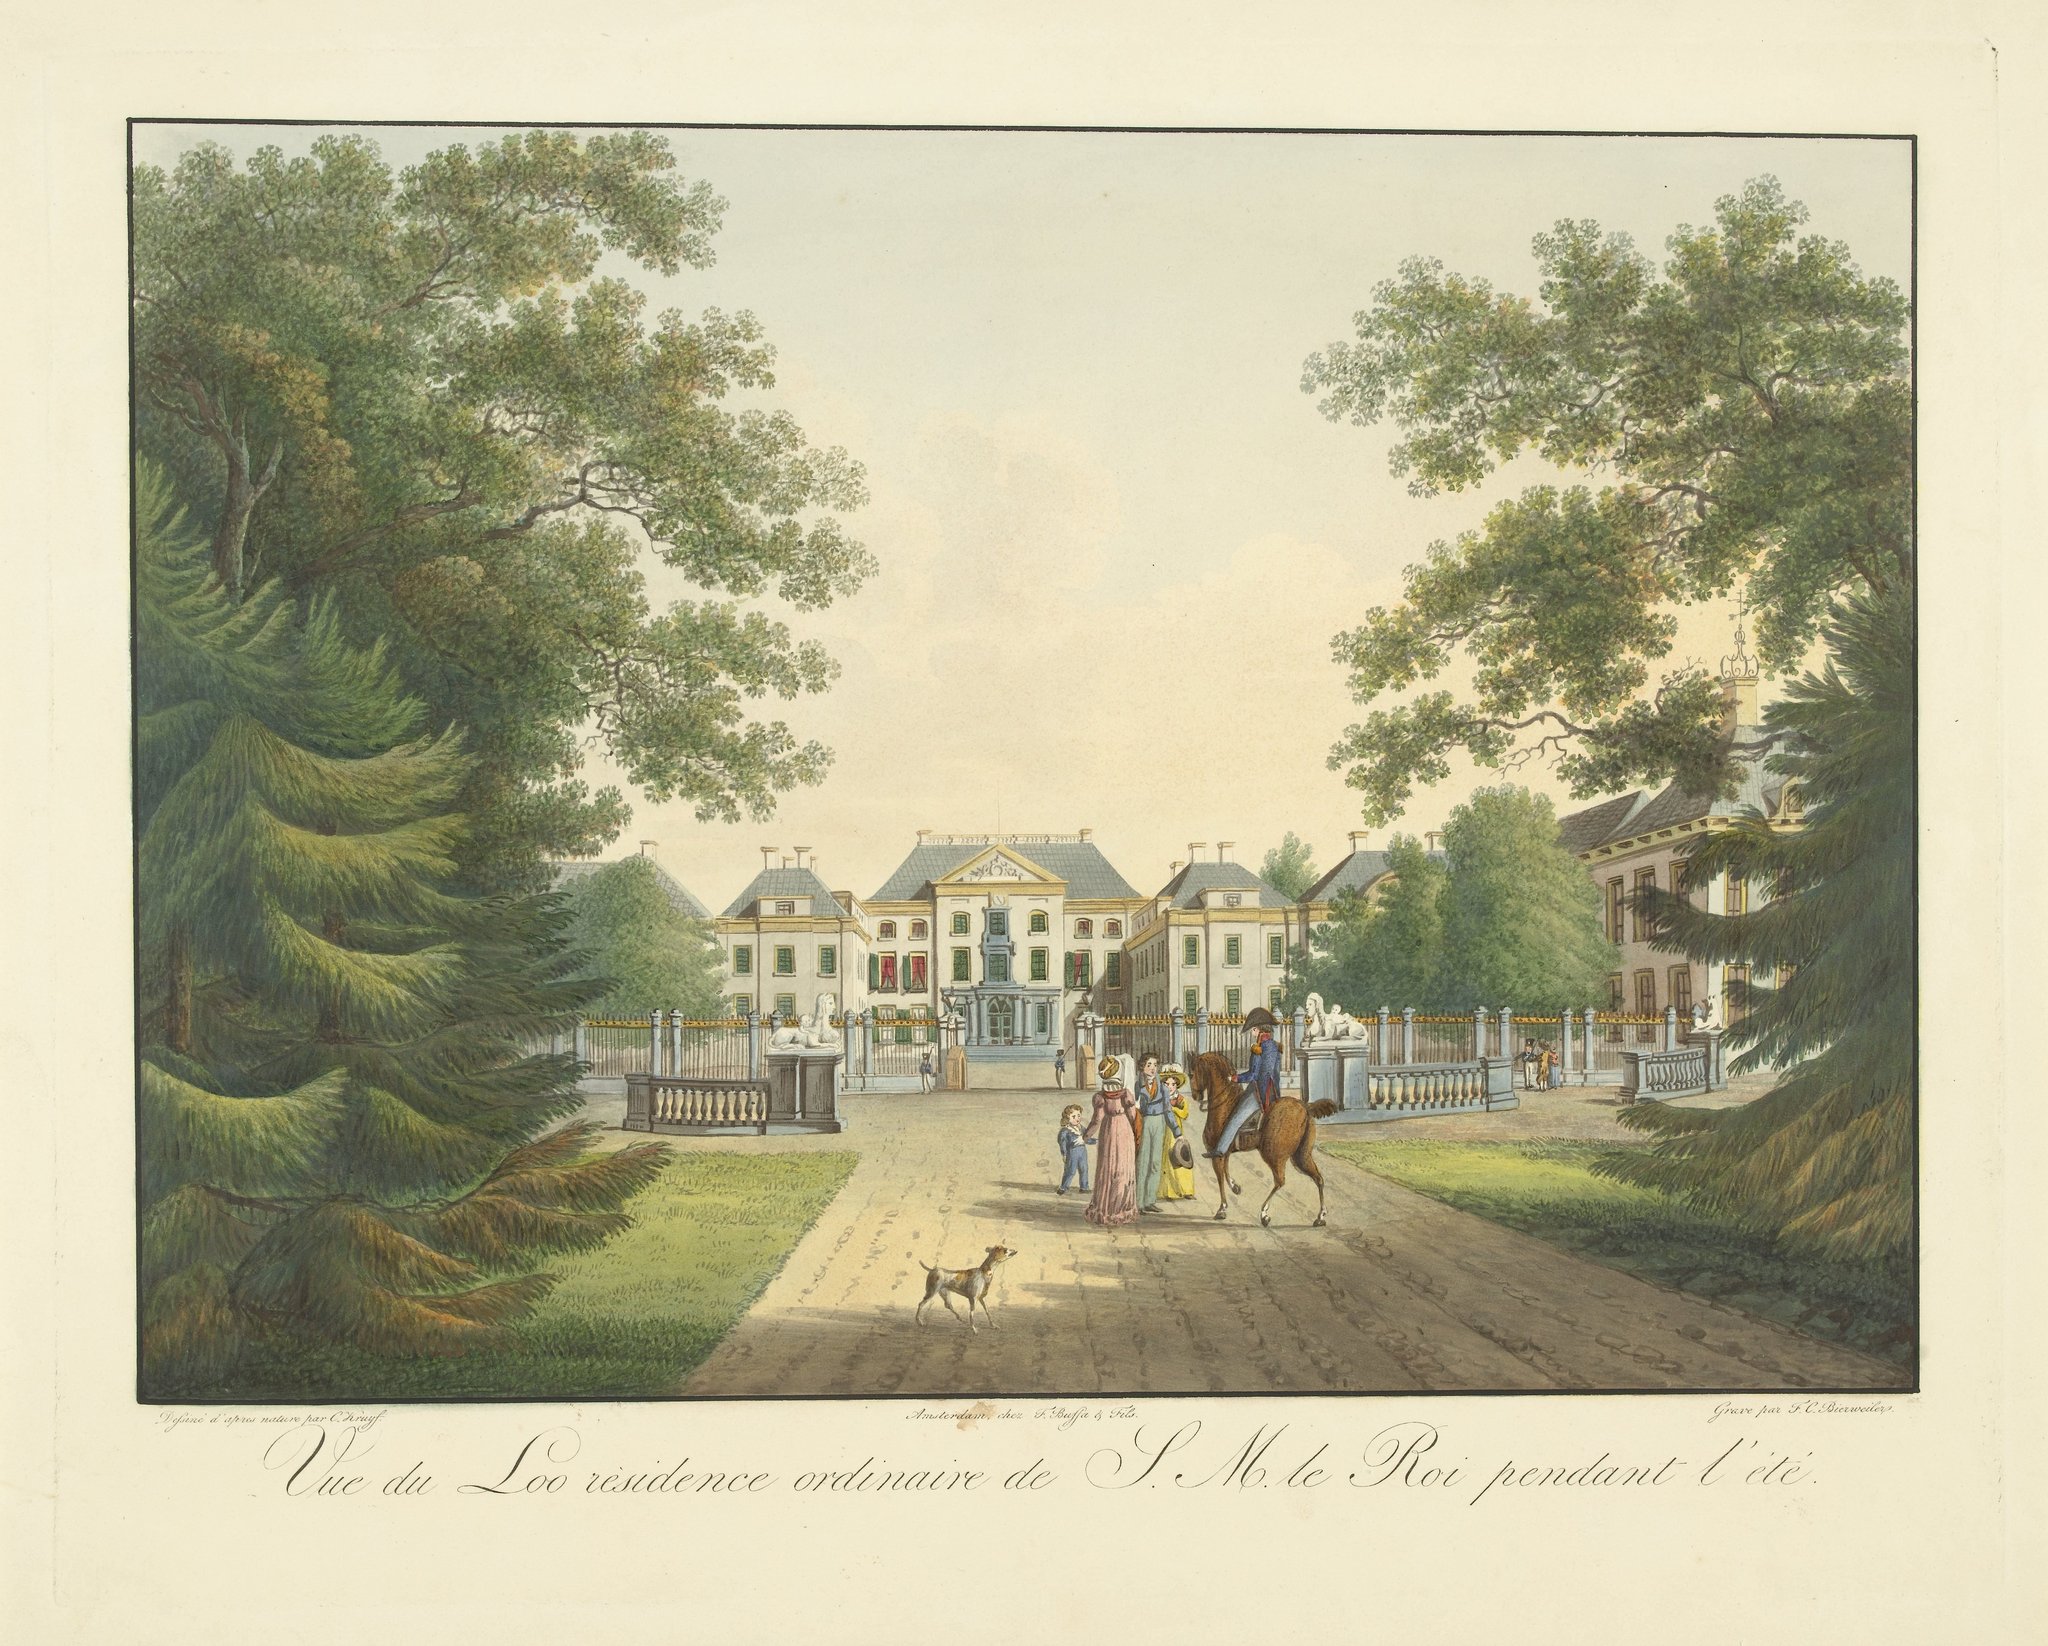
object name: print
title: Vue du Loo résidence ordinaire de S.M. le Roi pendant l'été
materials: paper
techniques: etching, hand coloring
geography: amsterdam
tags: paleis het loo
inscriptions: collector's mark: Lugt 2228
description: Prent naar tekening van Cornelis de Kruyff